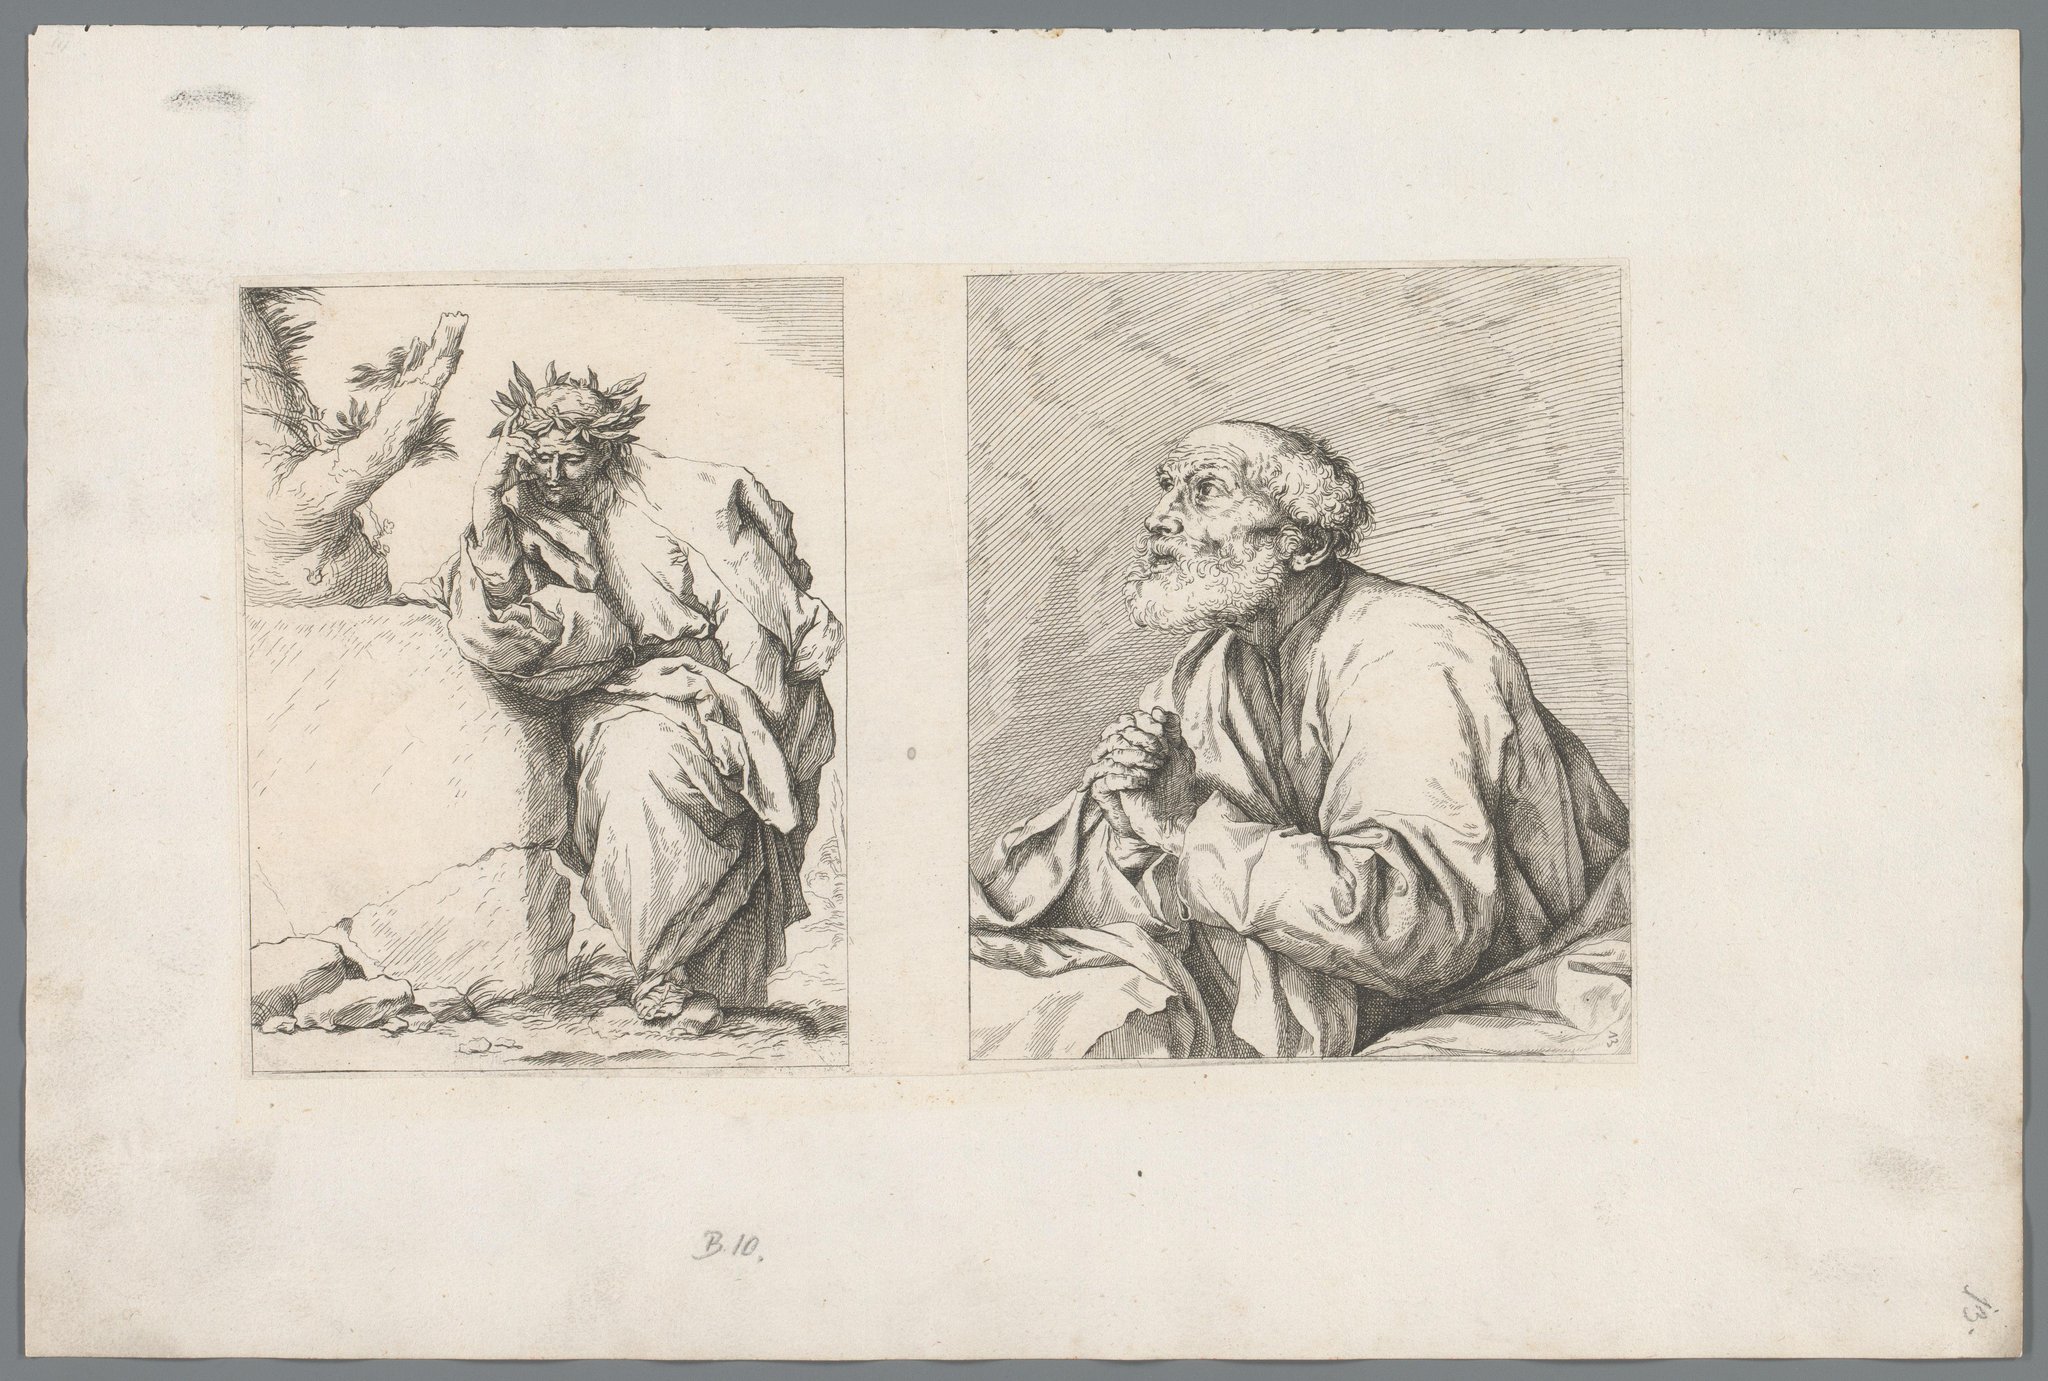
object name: print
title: Peinzende dichter en een biddende man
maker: Anonymous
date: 1602-1652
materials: paper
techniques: etching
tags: writer, poet, author, inspiration of the poet; 'furore poetico' (ripa), one person praying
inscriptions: collector's mark: Lugt 2228, collector's mark: Lugt 2760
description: Prent uit een serie van twaalf prenten en een titelprent.